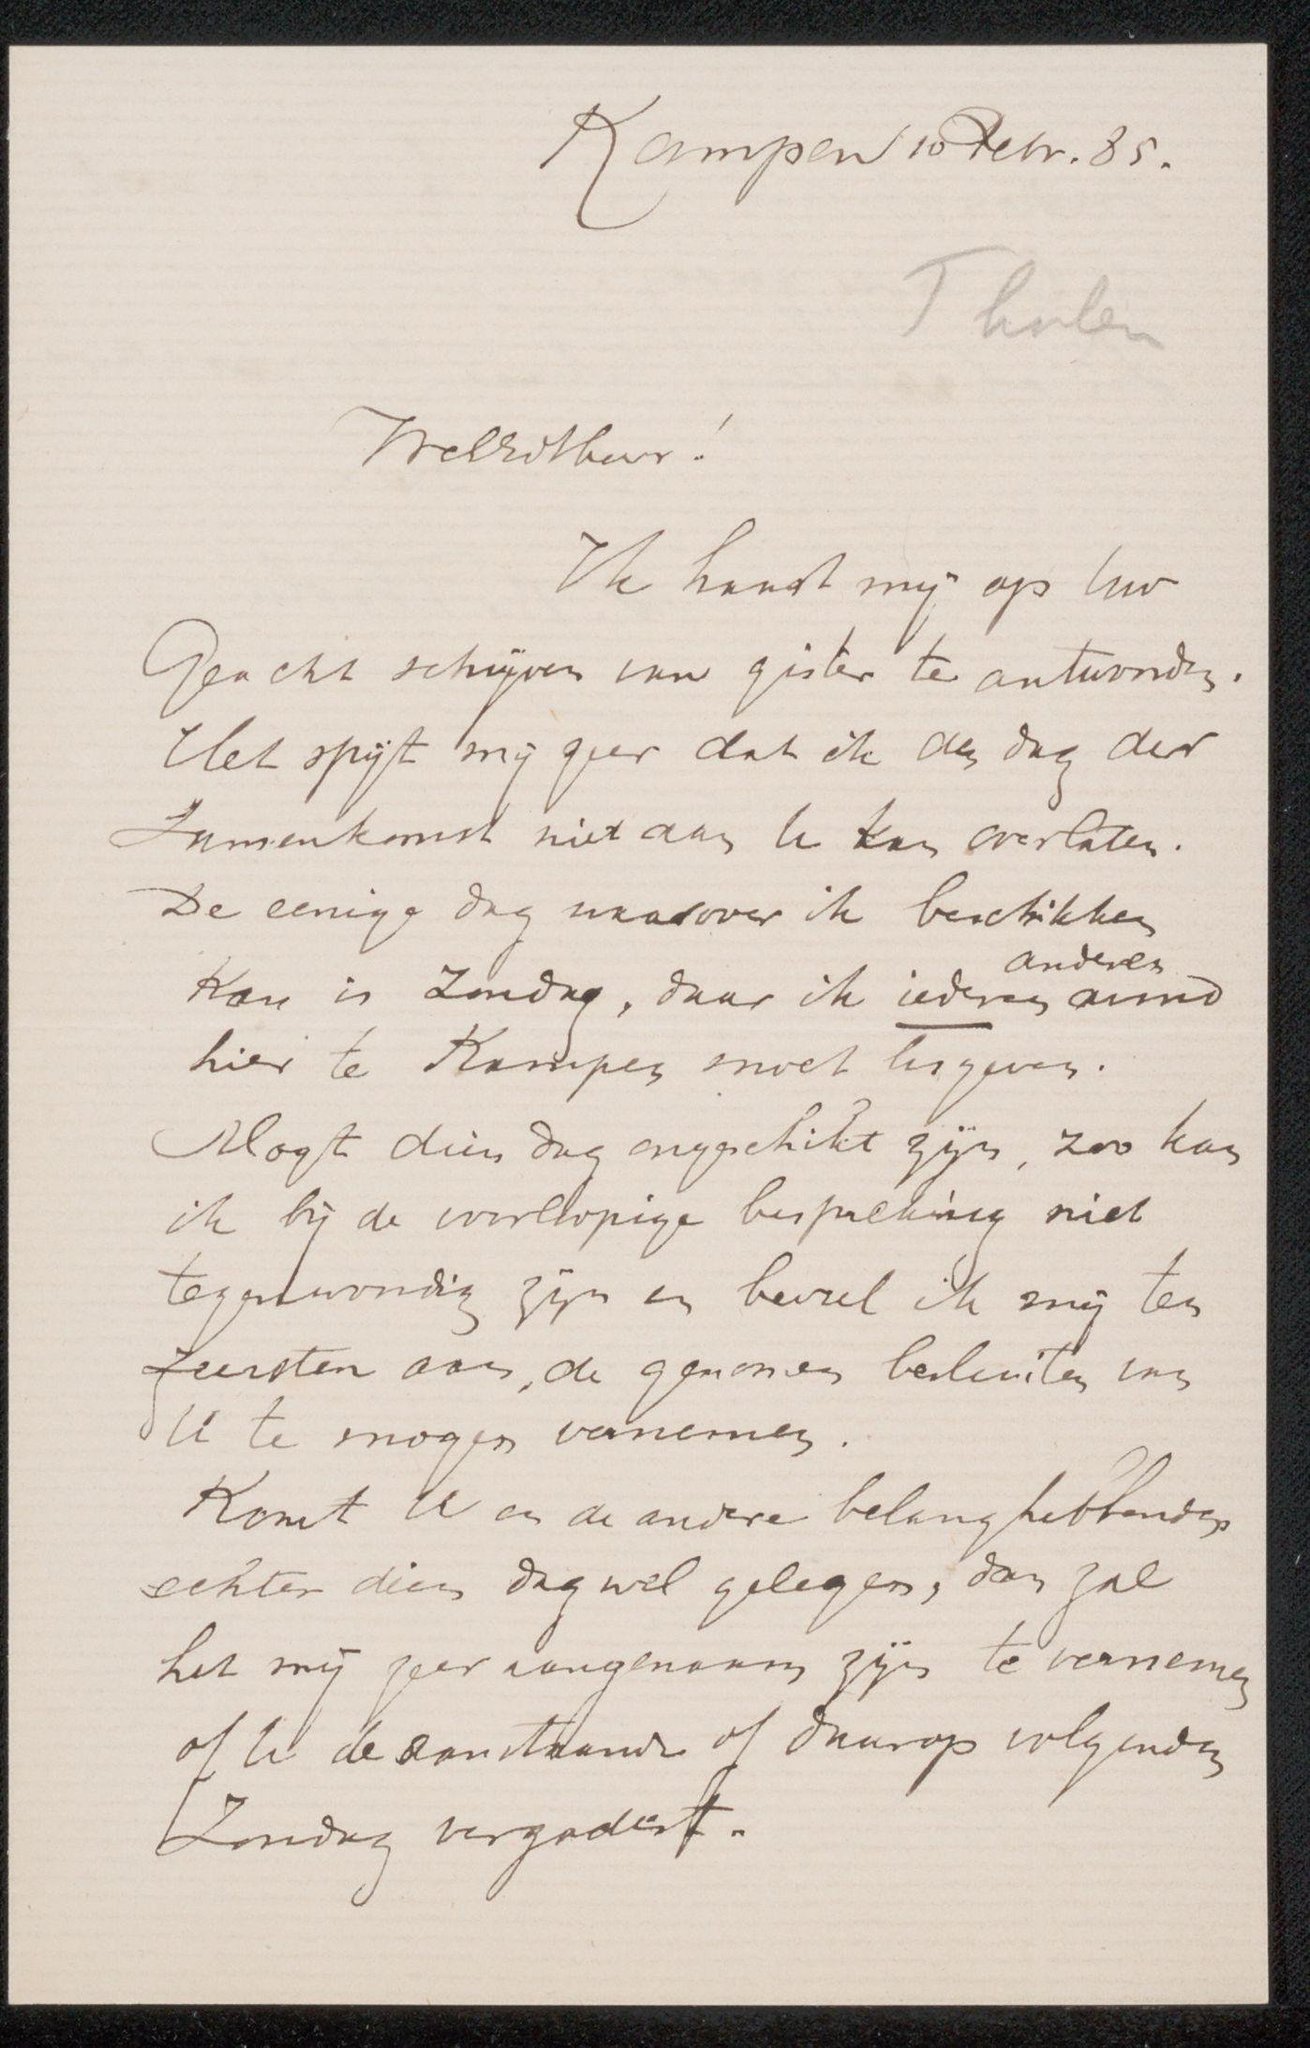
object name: letter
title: Brief aan Jan Veth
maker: willem bastiaan tholen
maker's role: draughtsman, painter, print maker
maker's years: 1860-1931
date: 1885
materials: ink, paper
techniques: pen, writing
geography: kampen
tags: dordrecht, amsterdam, painter, draughtsman, designer, jan veth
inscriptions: collector's mark: ‘RPK’